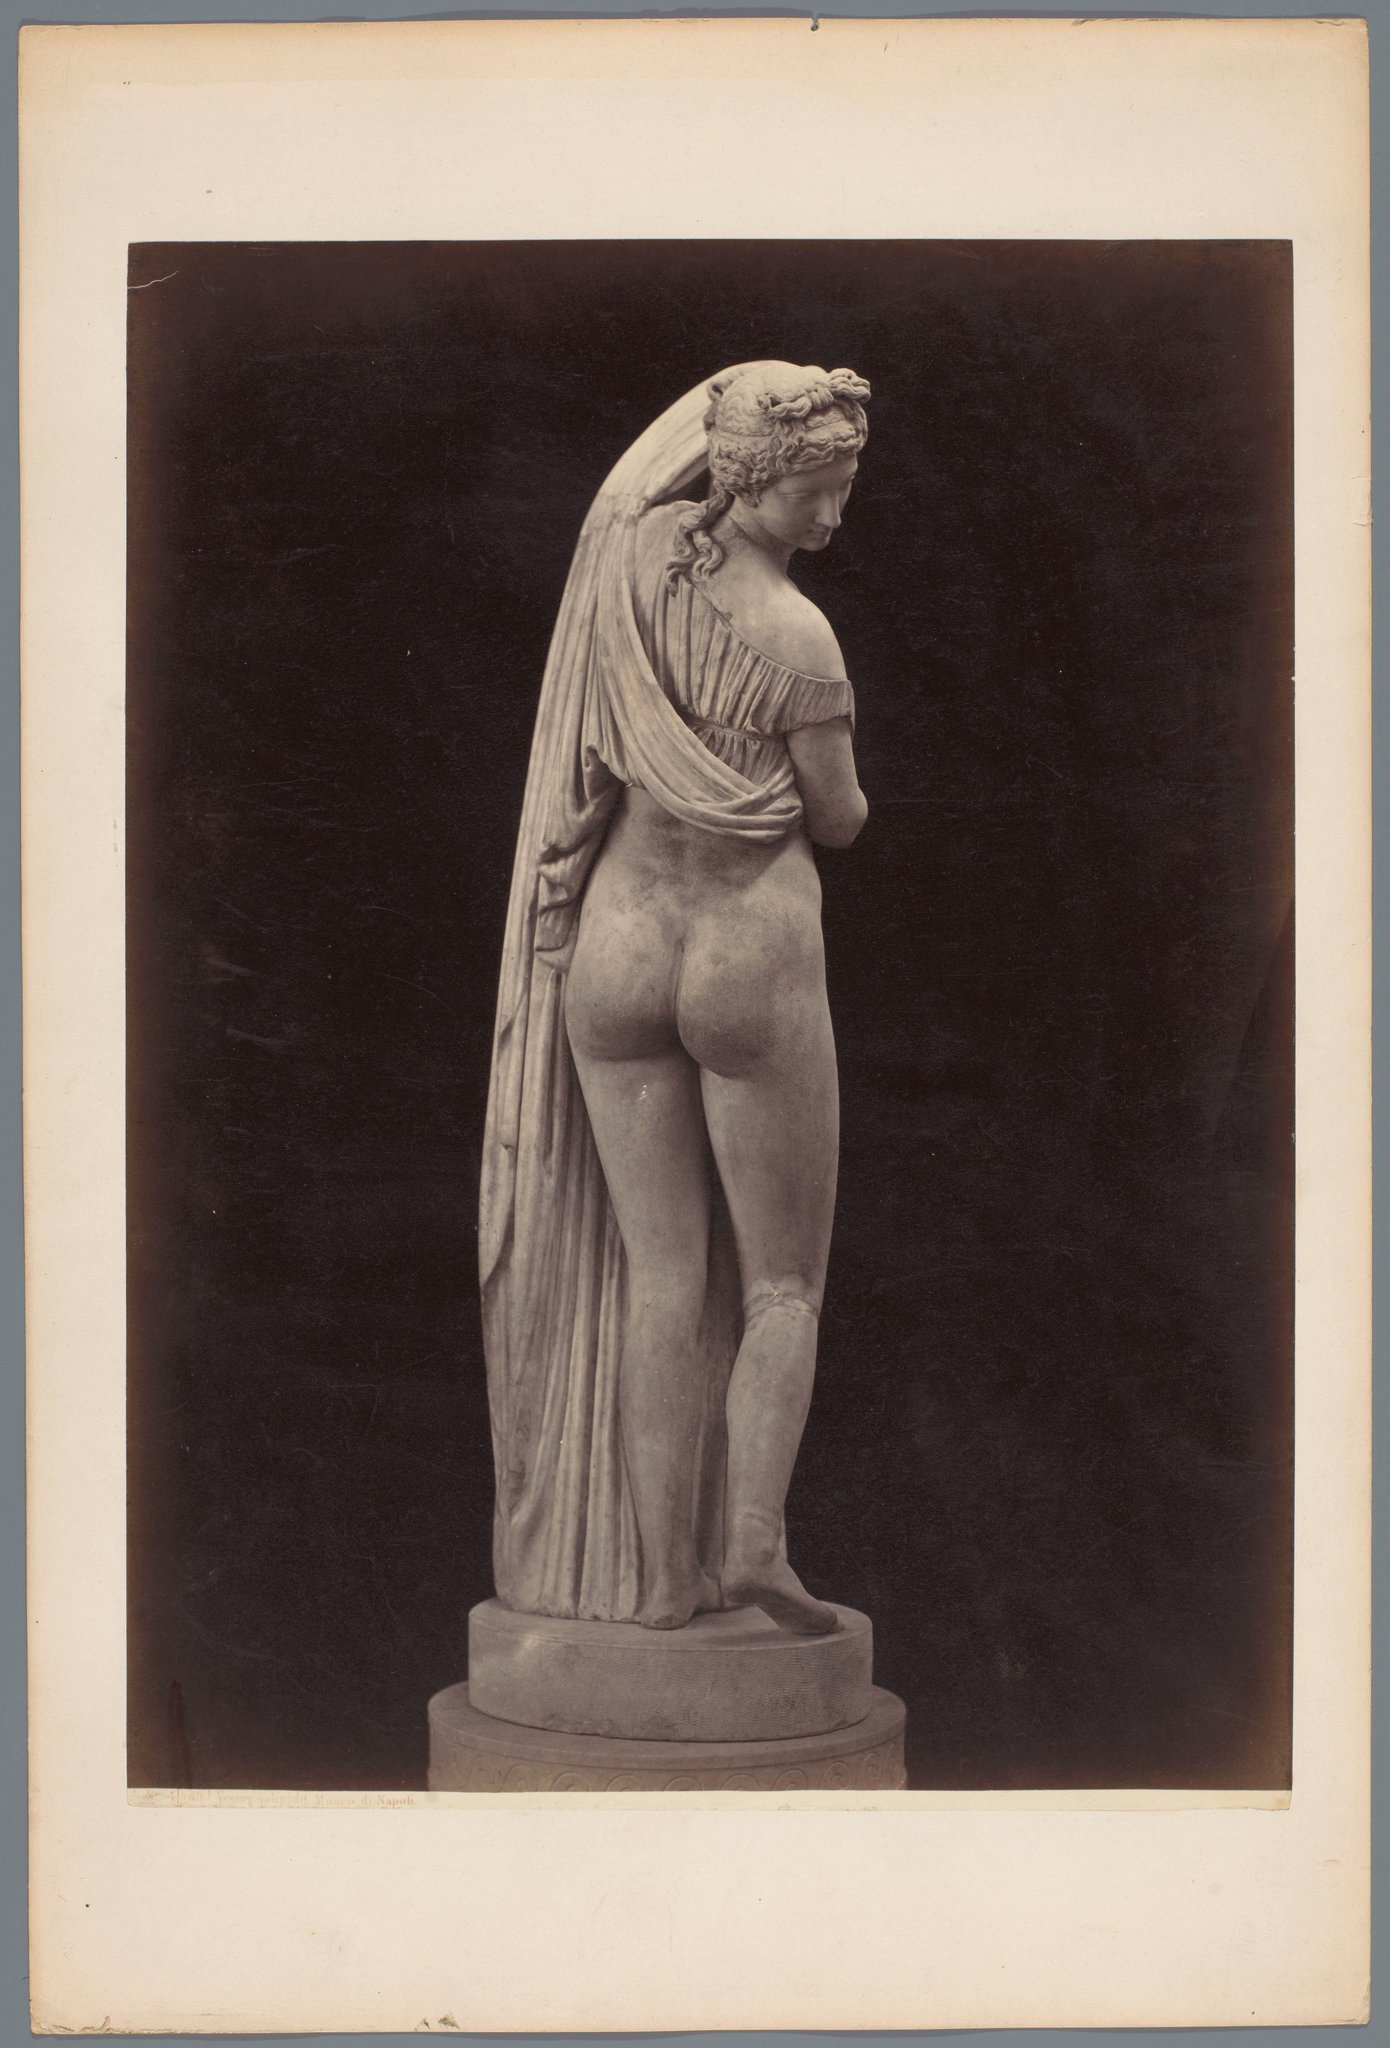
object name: photograph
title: Venus Callipyge in het Museo Nazionale te Napels, op de rug gezien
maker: Anonymous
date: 1875-1900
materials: cardboard, photographic support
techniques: albumen print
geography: naples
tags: woman (showing herself) undressed, quasi-nude, (story of) venus (aphrodite), sculpture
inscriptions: collector's mark: Lugt 3937, number: ‘4409’